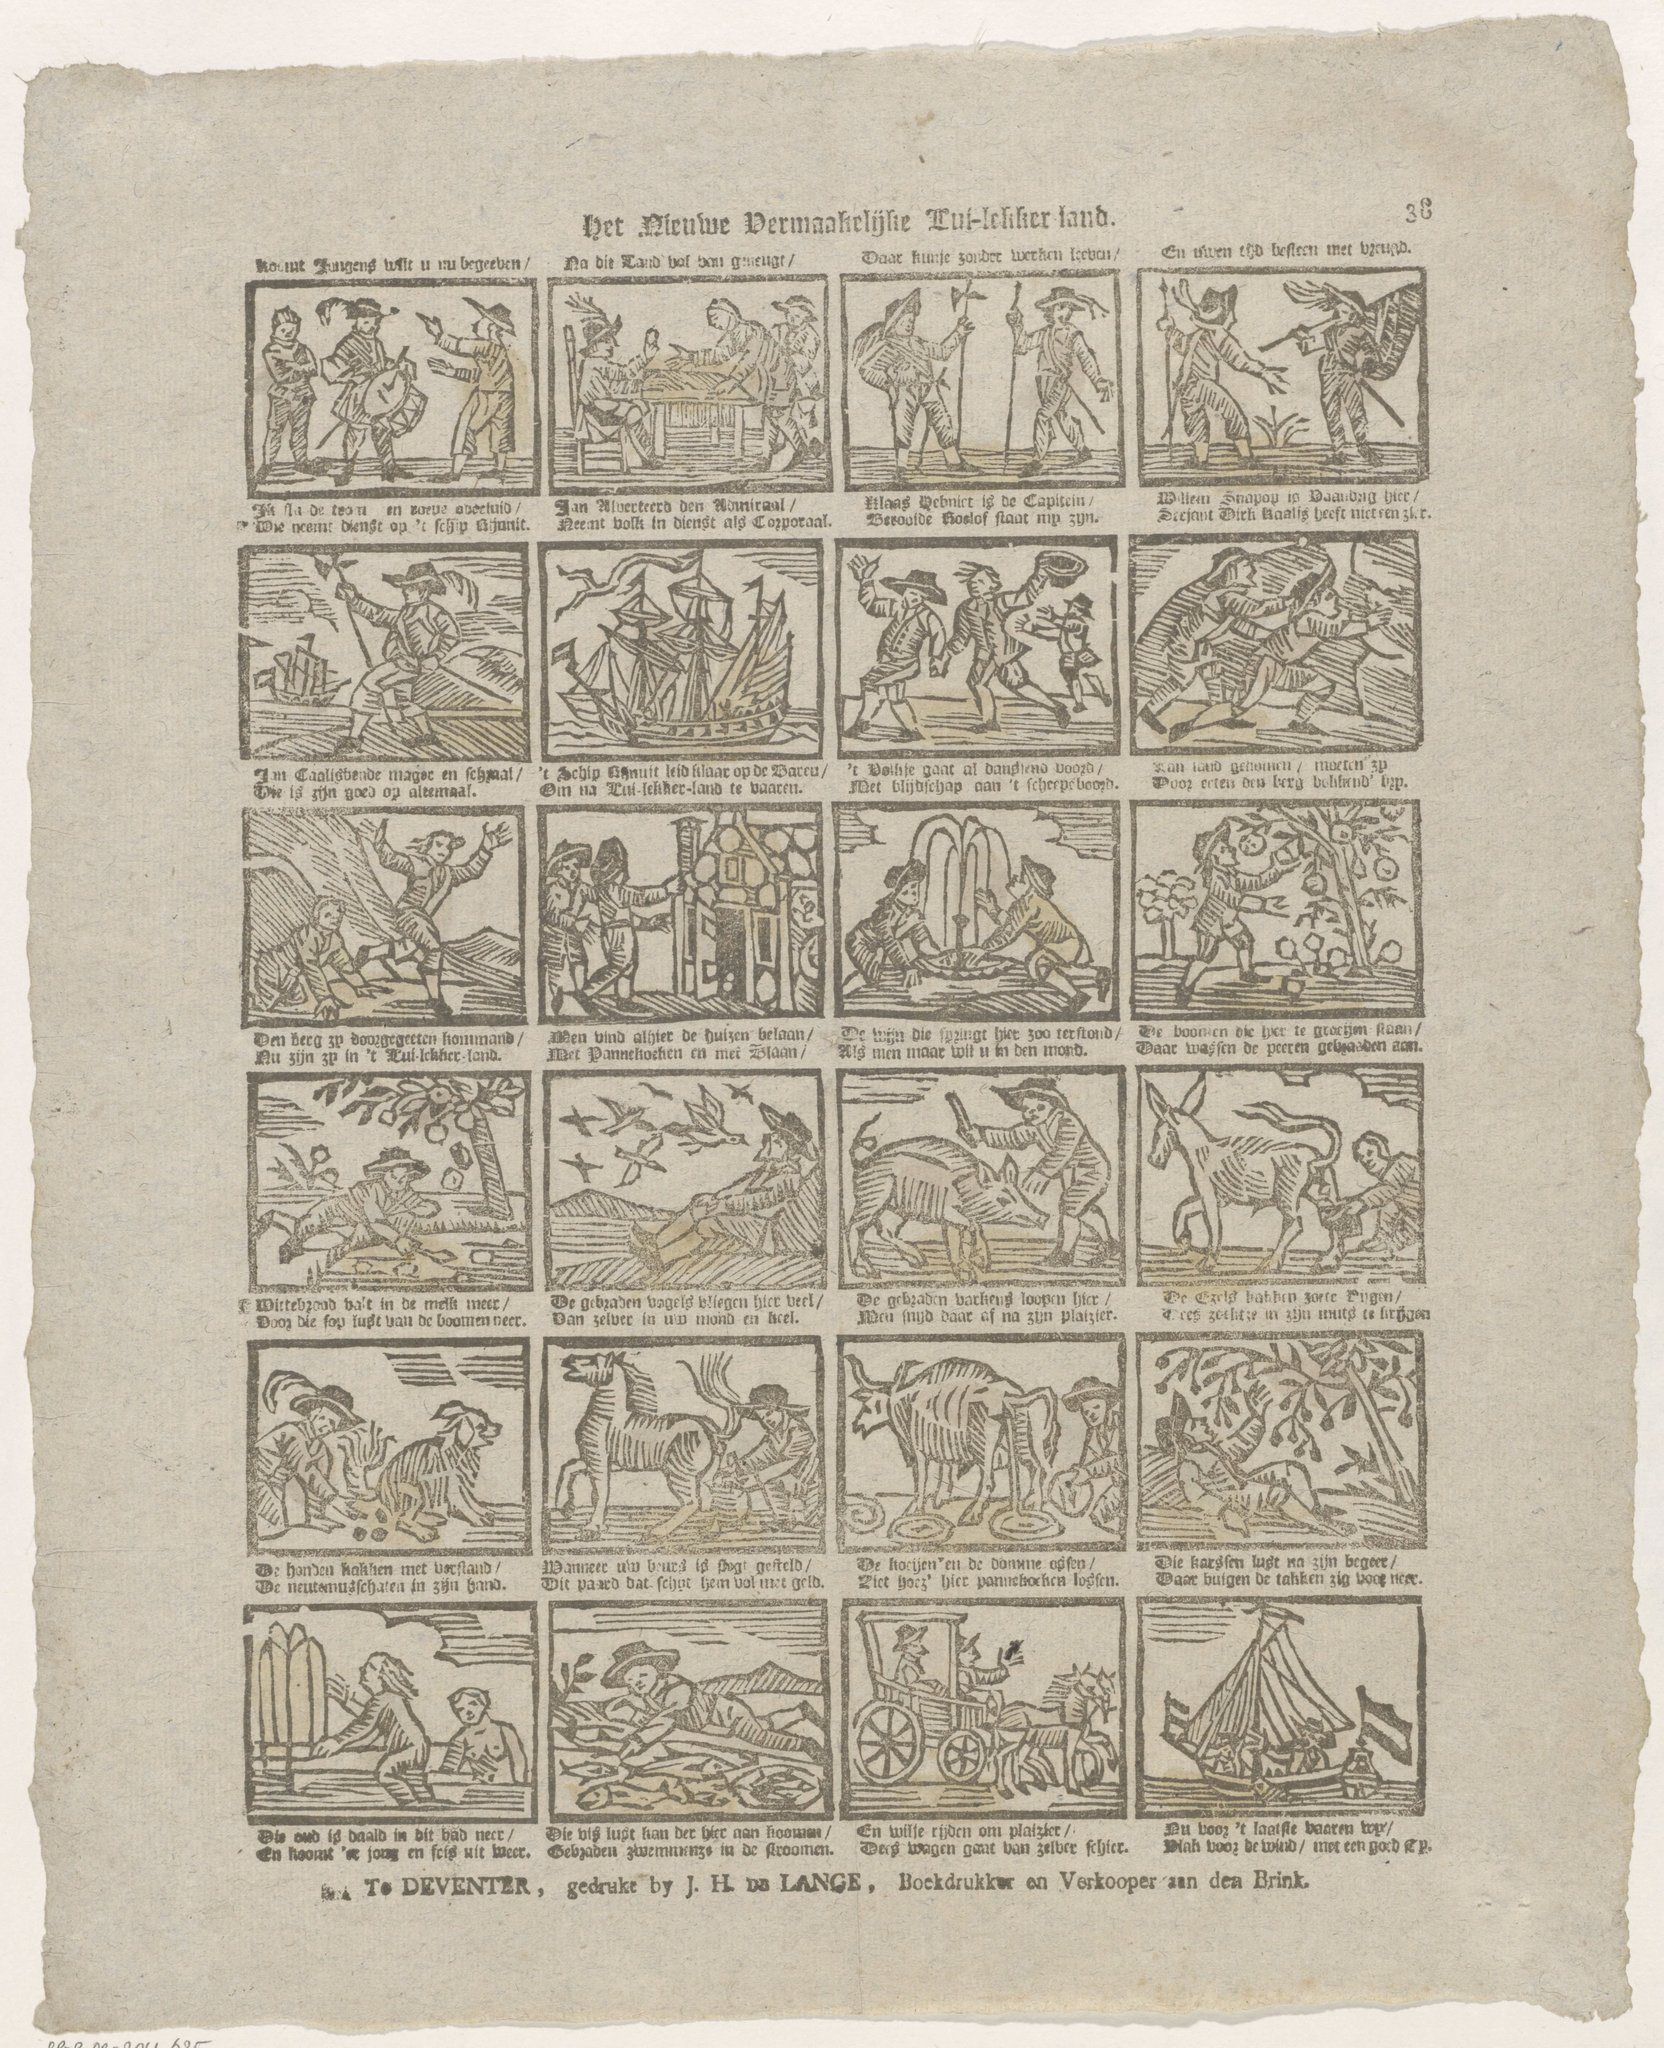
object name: print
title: Het nieuwe vermaakelijke Lui-lekker land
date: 1787-1822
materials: paper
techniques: colour, letterpress printing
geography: deventer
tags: land of cockaigne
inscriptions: collector's mark: Lugt 2760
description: Blad met 24 voorstellingen van het Luilekkerland. Onder elke afbeelding een tweeregelig vers. Genummerd rechtsboven: 38.